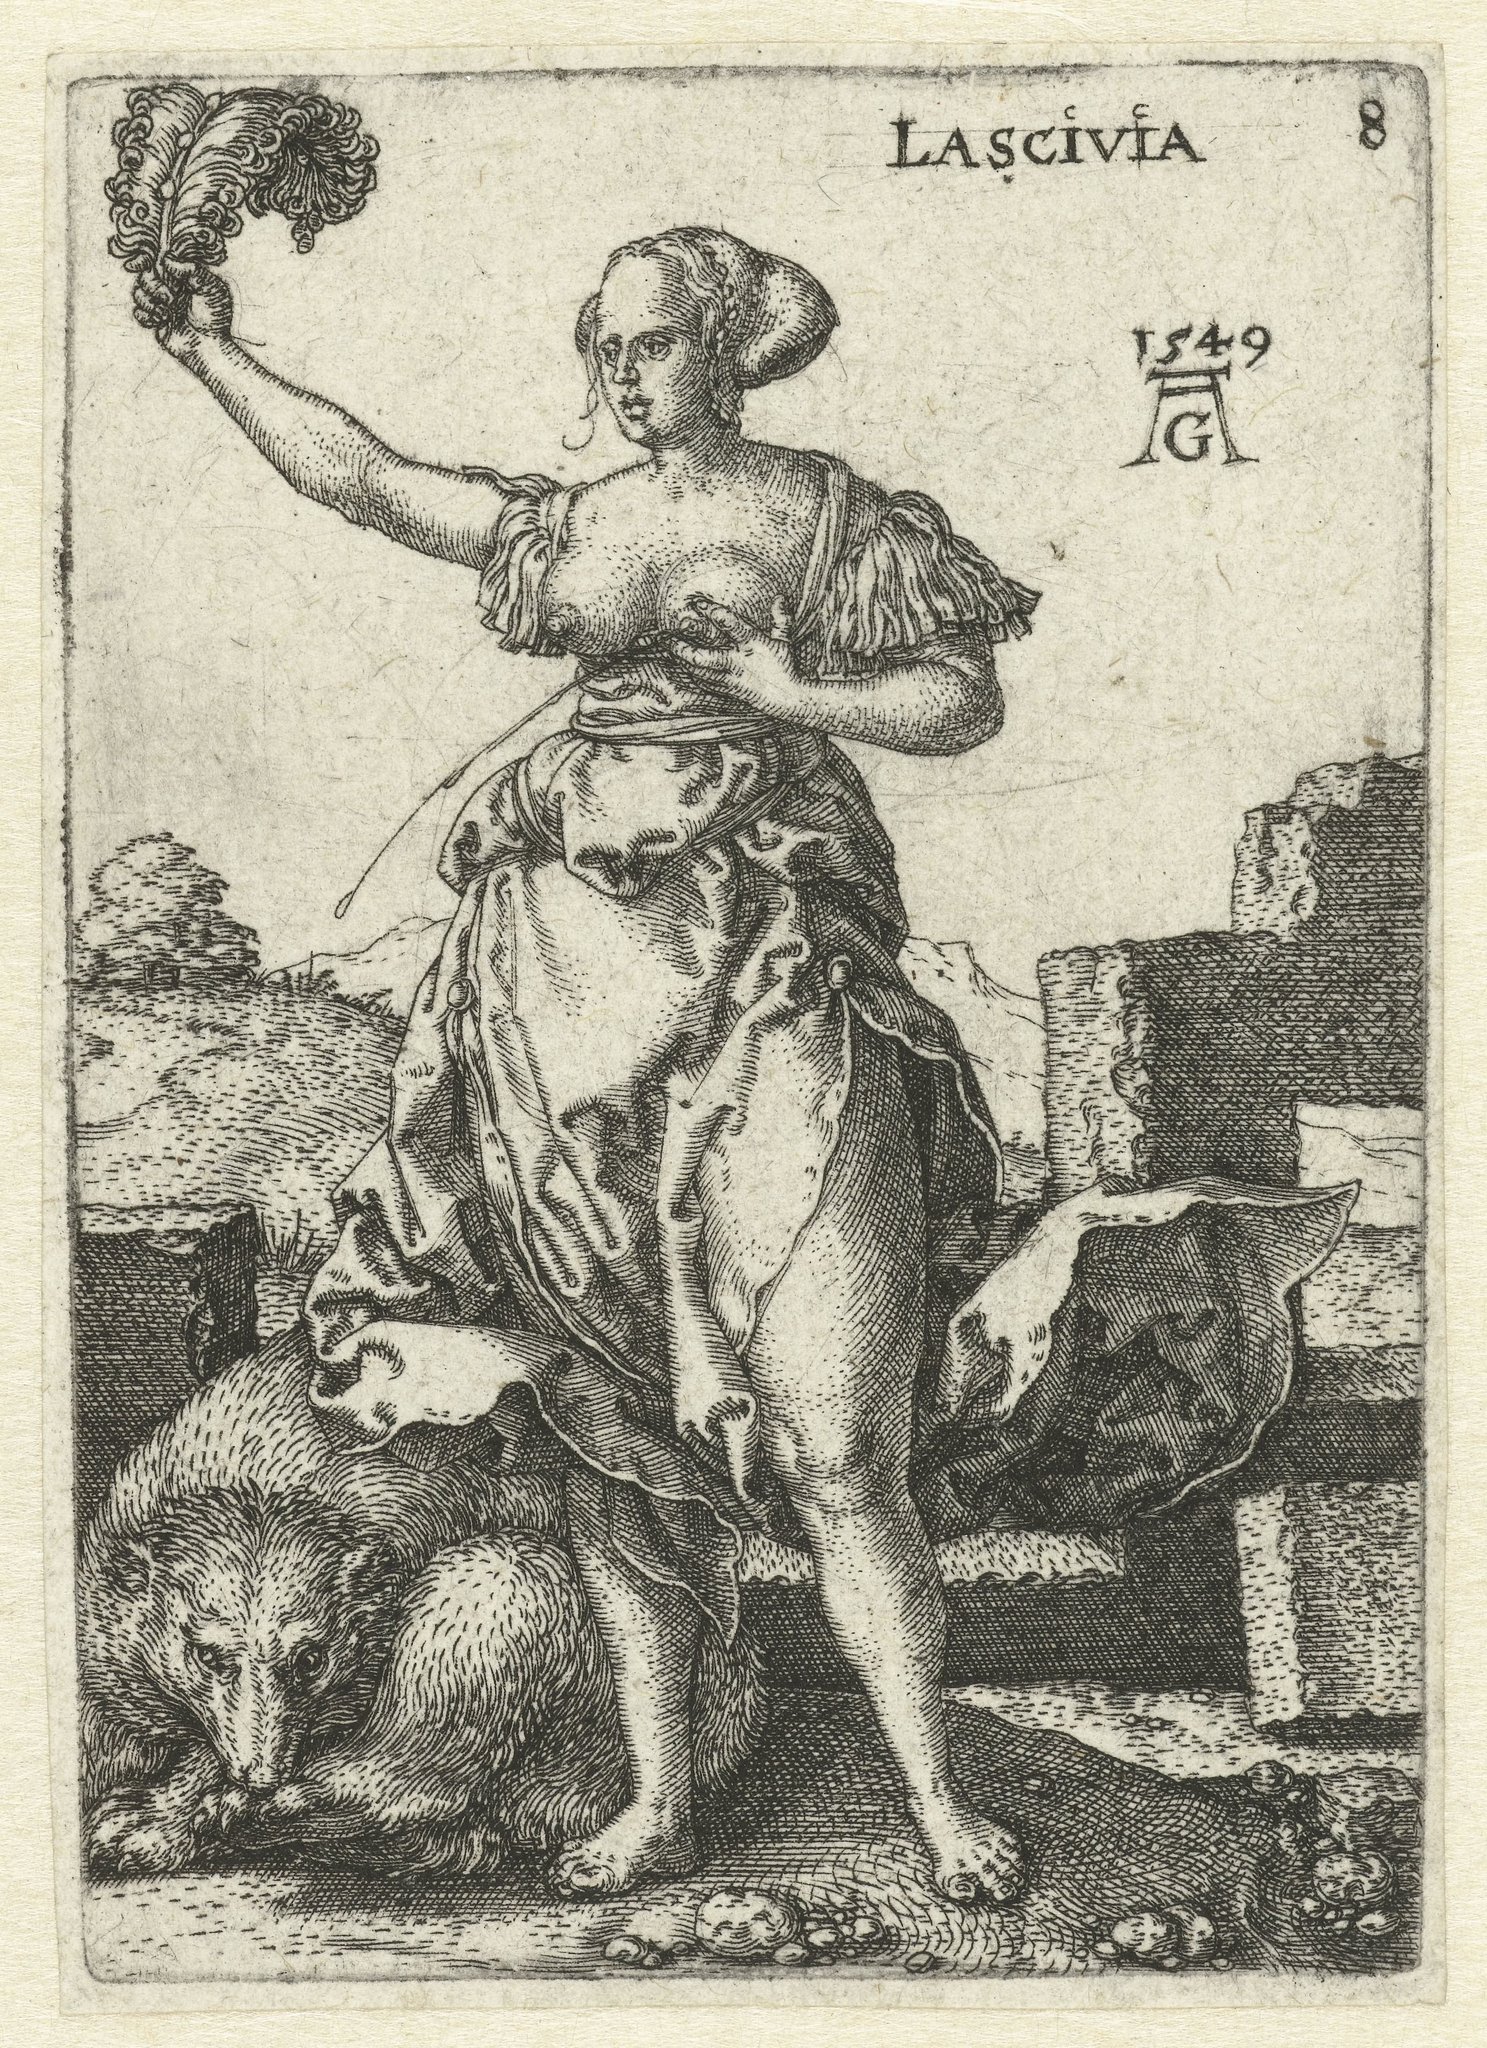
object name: print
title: Lascivia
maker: heinrich aldegrever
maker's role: draughtsman, print maker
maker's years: 1502-1561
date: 1549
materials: paper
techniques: engraving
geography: germany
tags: licentiousness, lasciviousness; 'lascivia', 'licenza' (ripa) (+ abstract concept represented by female figure)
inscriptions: date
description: Personificatie van losbandigheid (Lascivia). Een vrouw, in de rechterhand houdt zij een veer omhoog gestoken, met haar linkerhand spuit zij melk uit haar borst, bij haar zit een beer zich te wassen. Achtste prent uit een serie van veertien met personificaties van deugden en ondeugden.